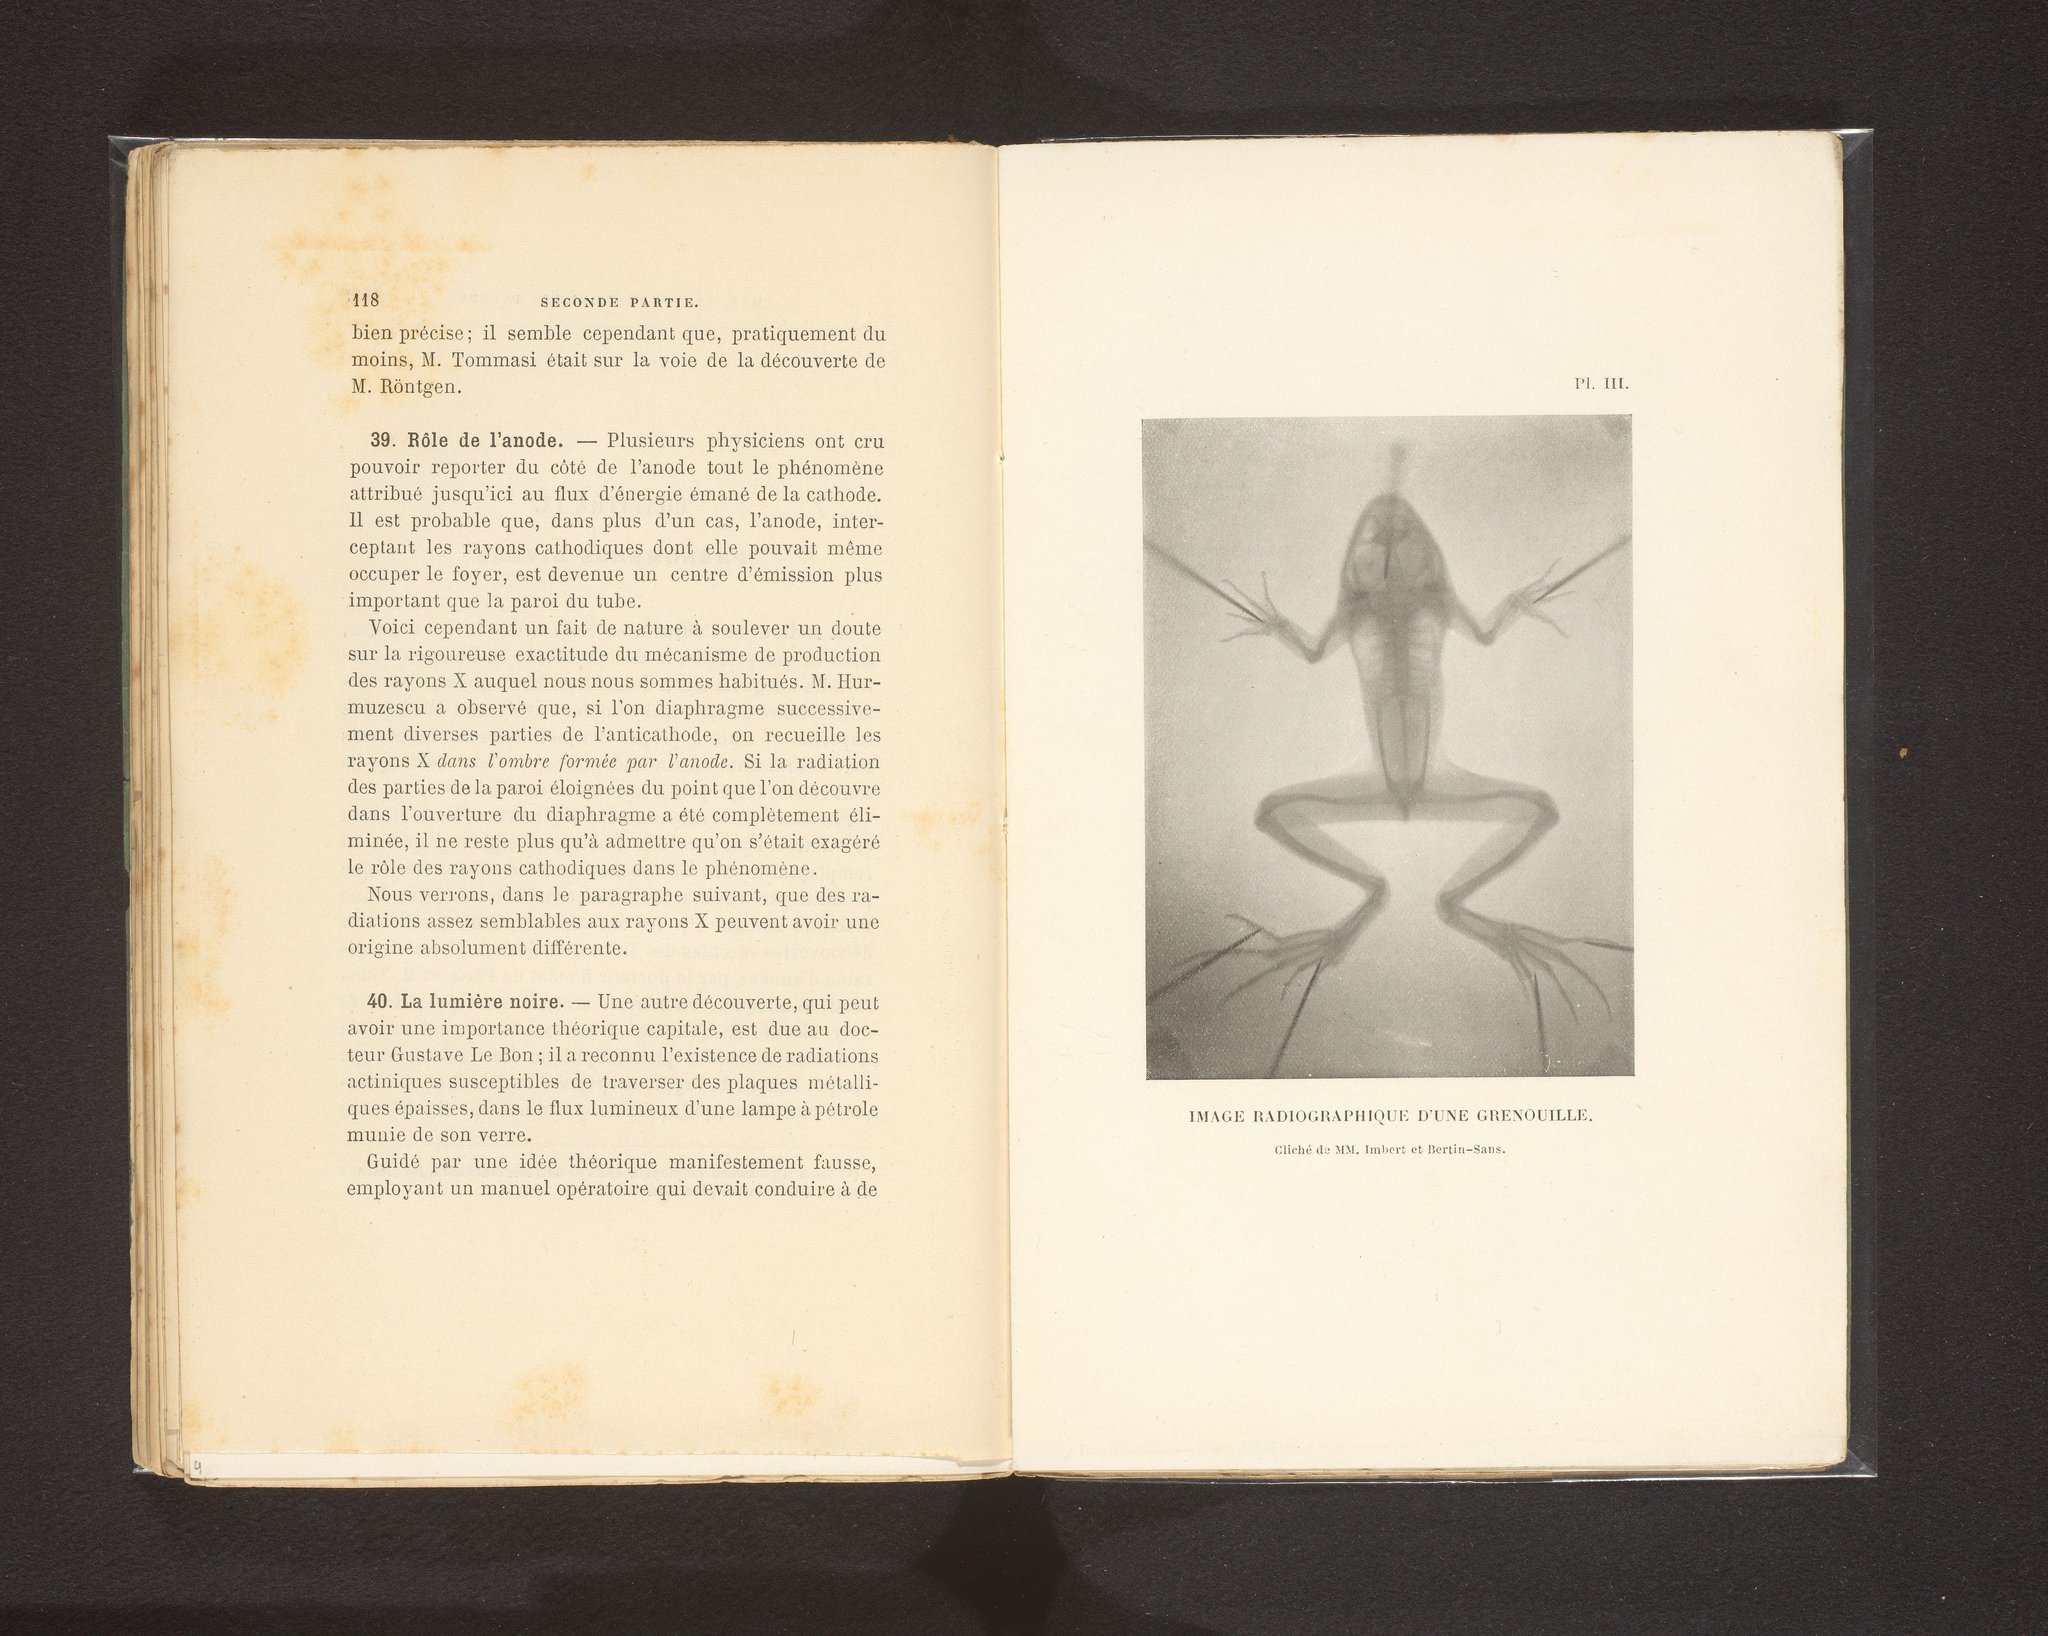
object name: page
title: Röntgenopname van een kikker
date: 1886-1896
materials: paper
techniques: autotype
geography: paris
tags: tailless amphibians: frog, x-ray examination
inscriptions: number: ‘Pl. III.’